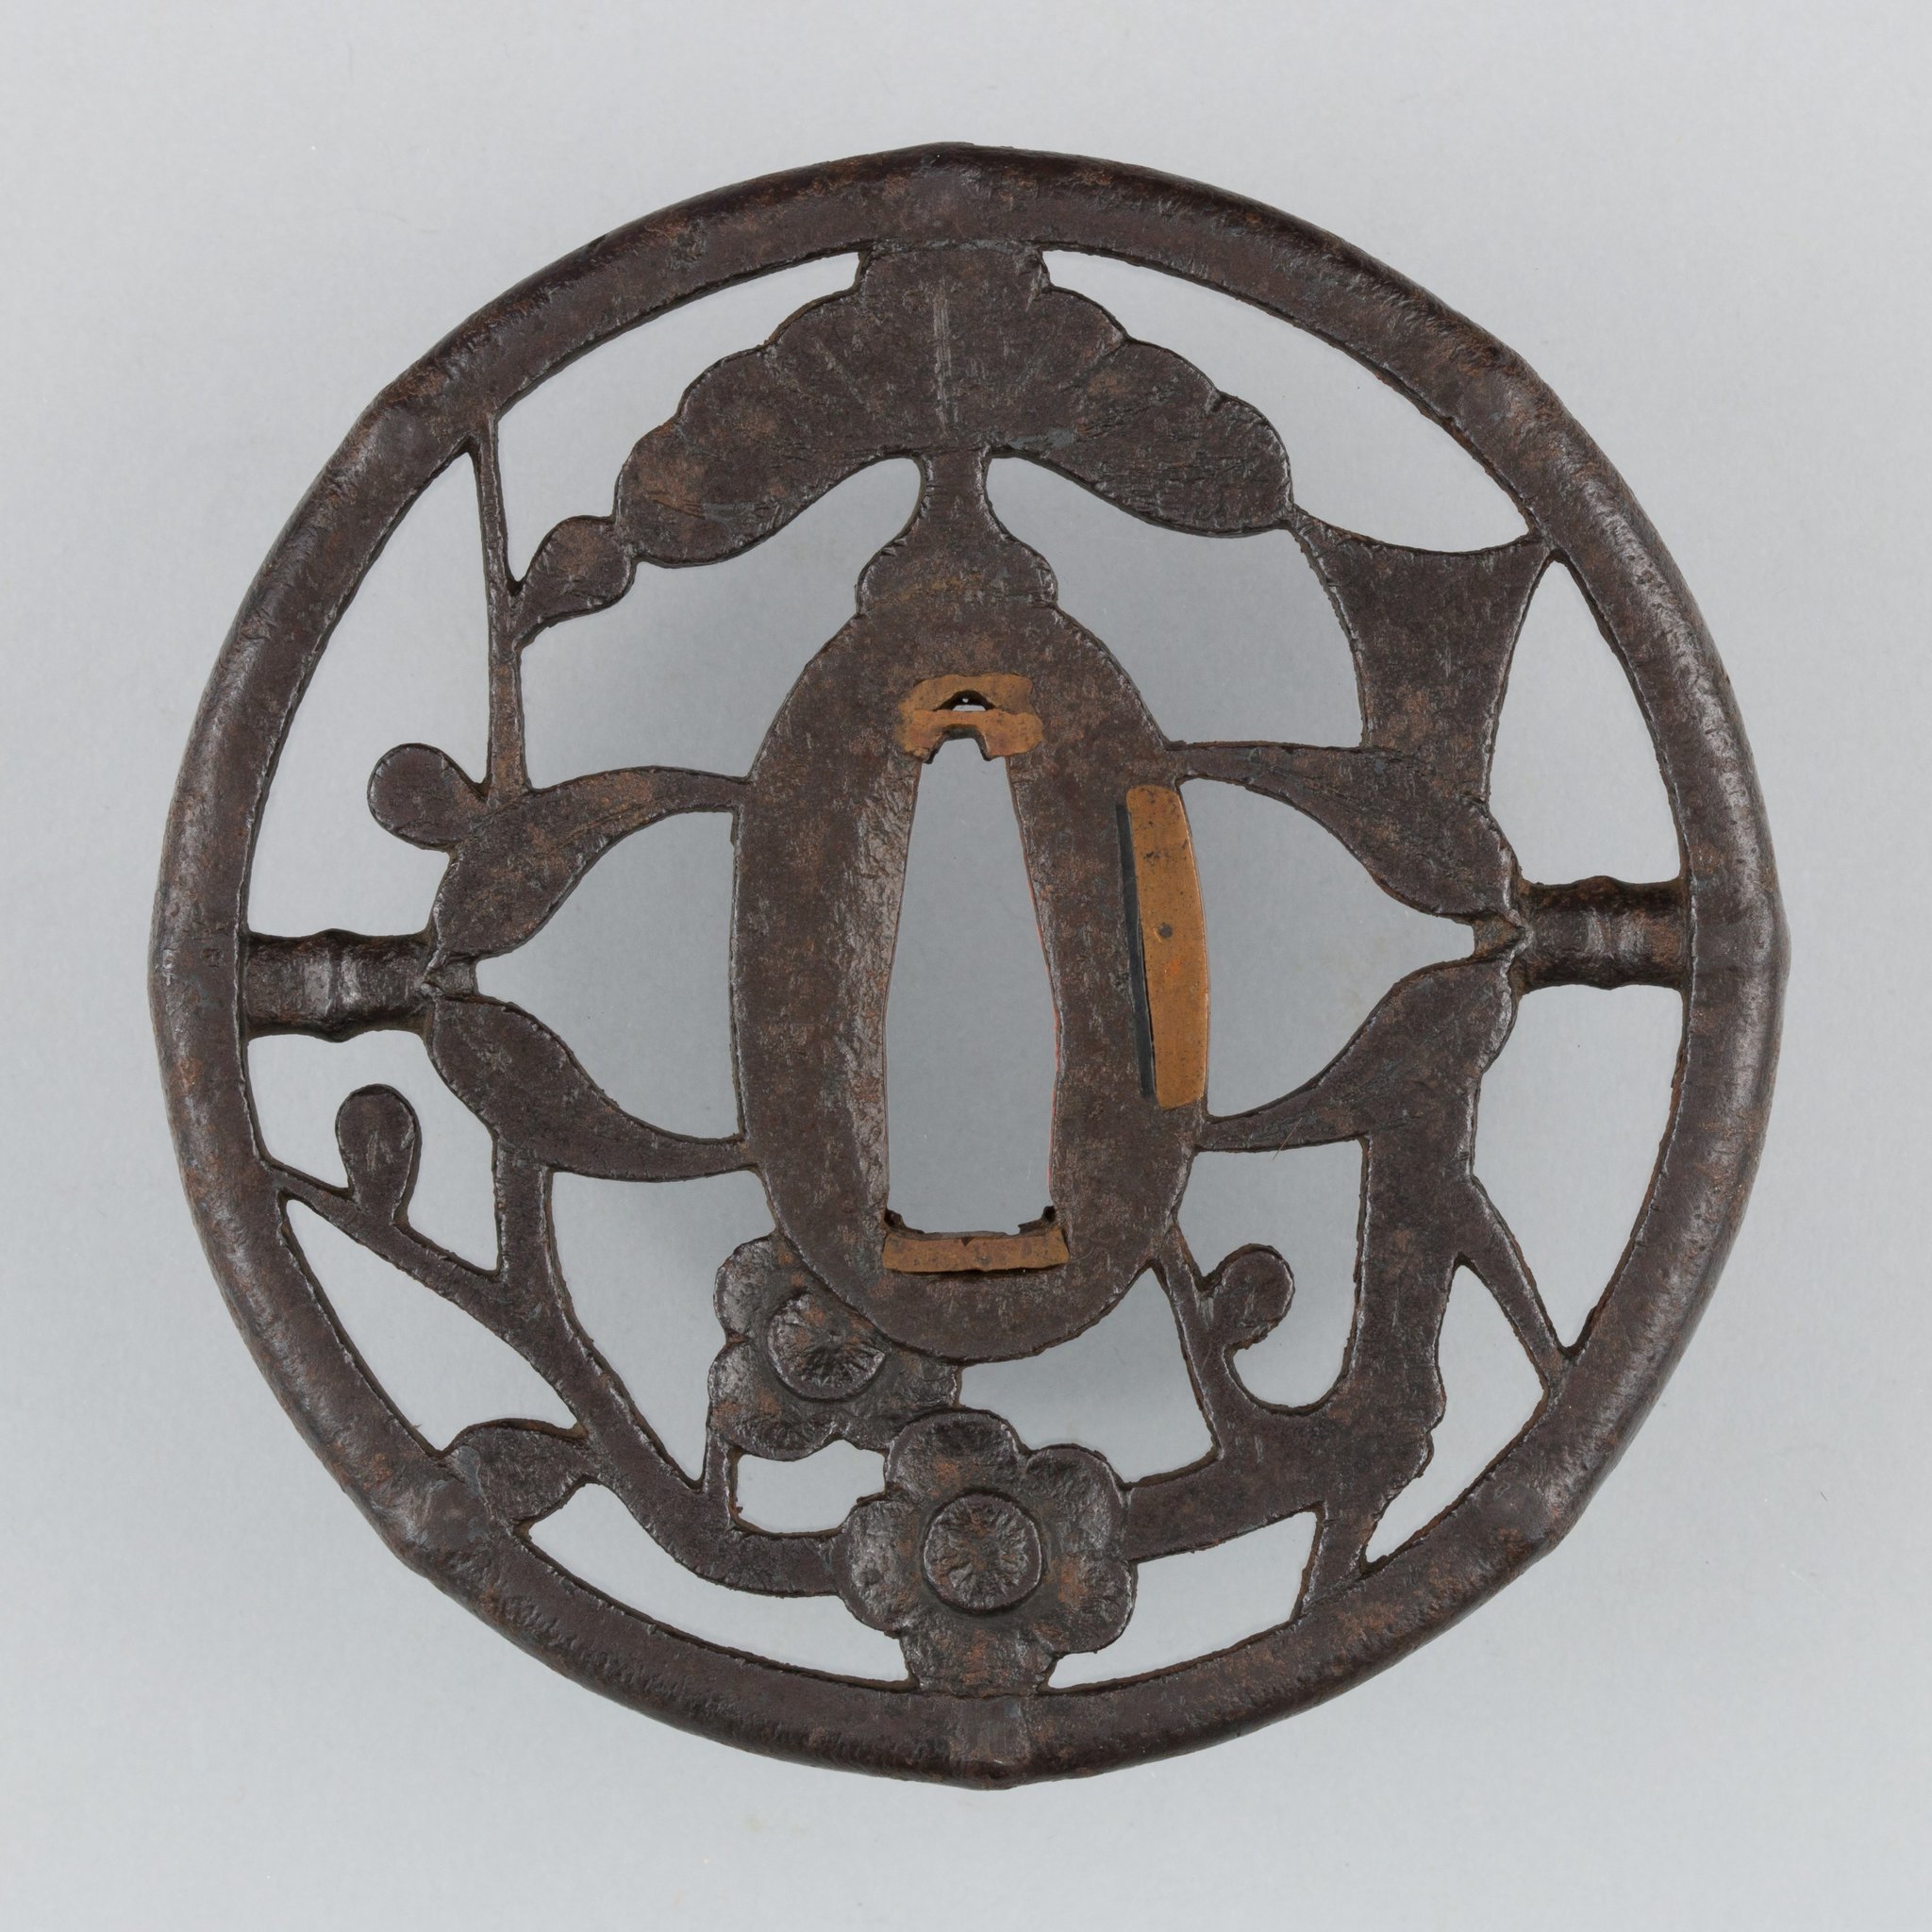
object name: sword guard tsuba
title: Sword Guard (Tsuba)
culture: japanese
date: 1601-1700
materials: copper, iron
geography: japan